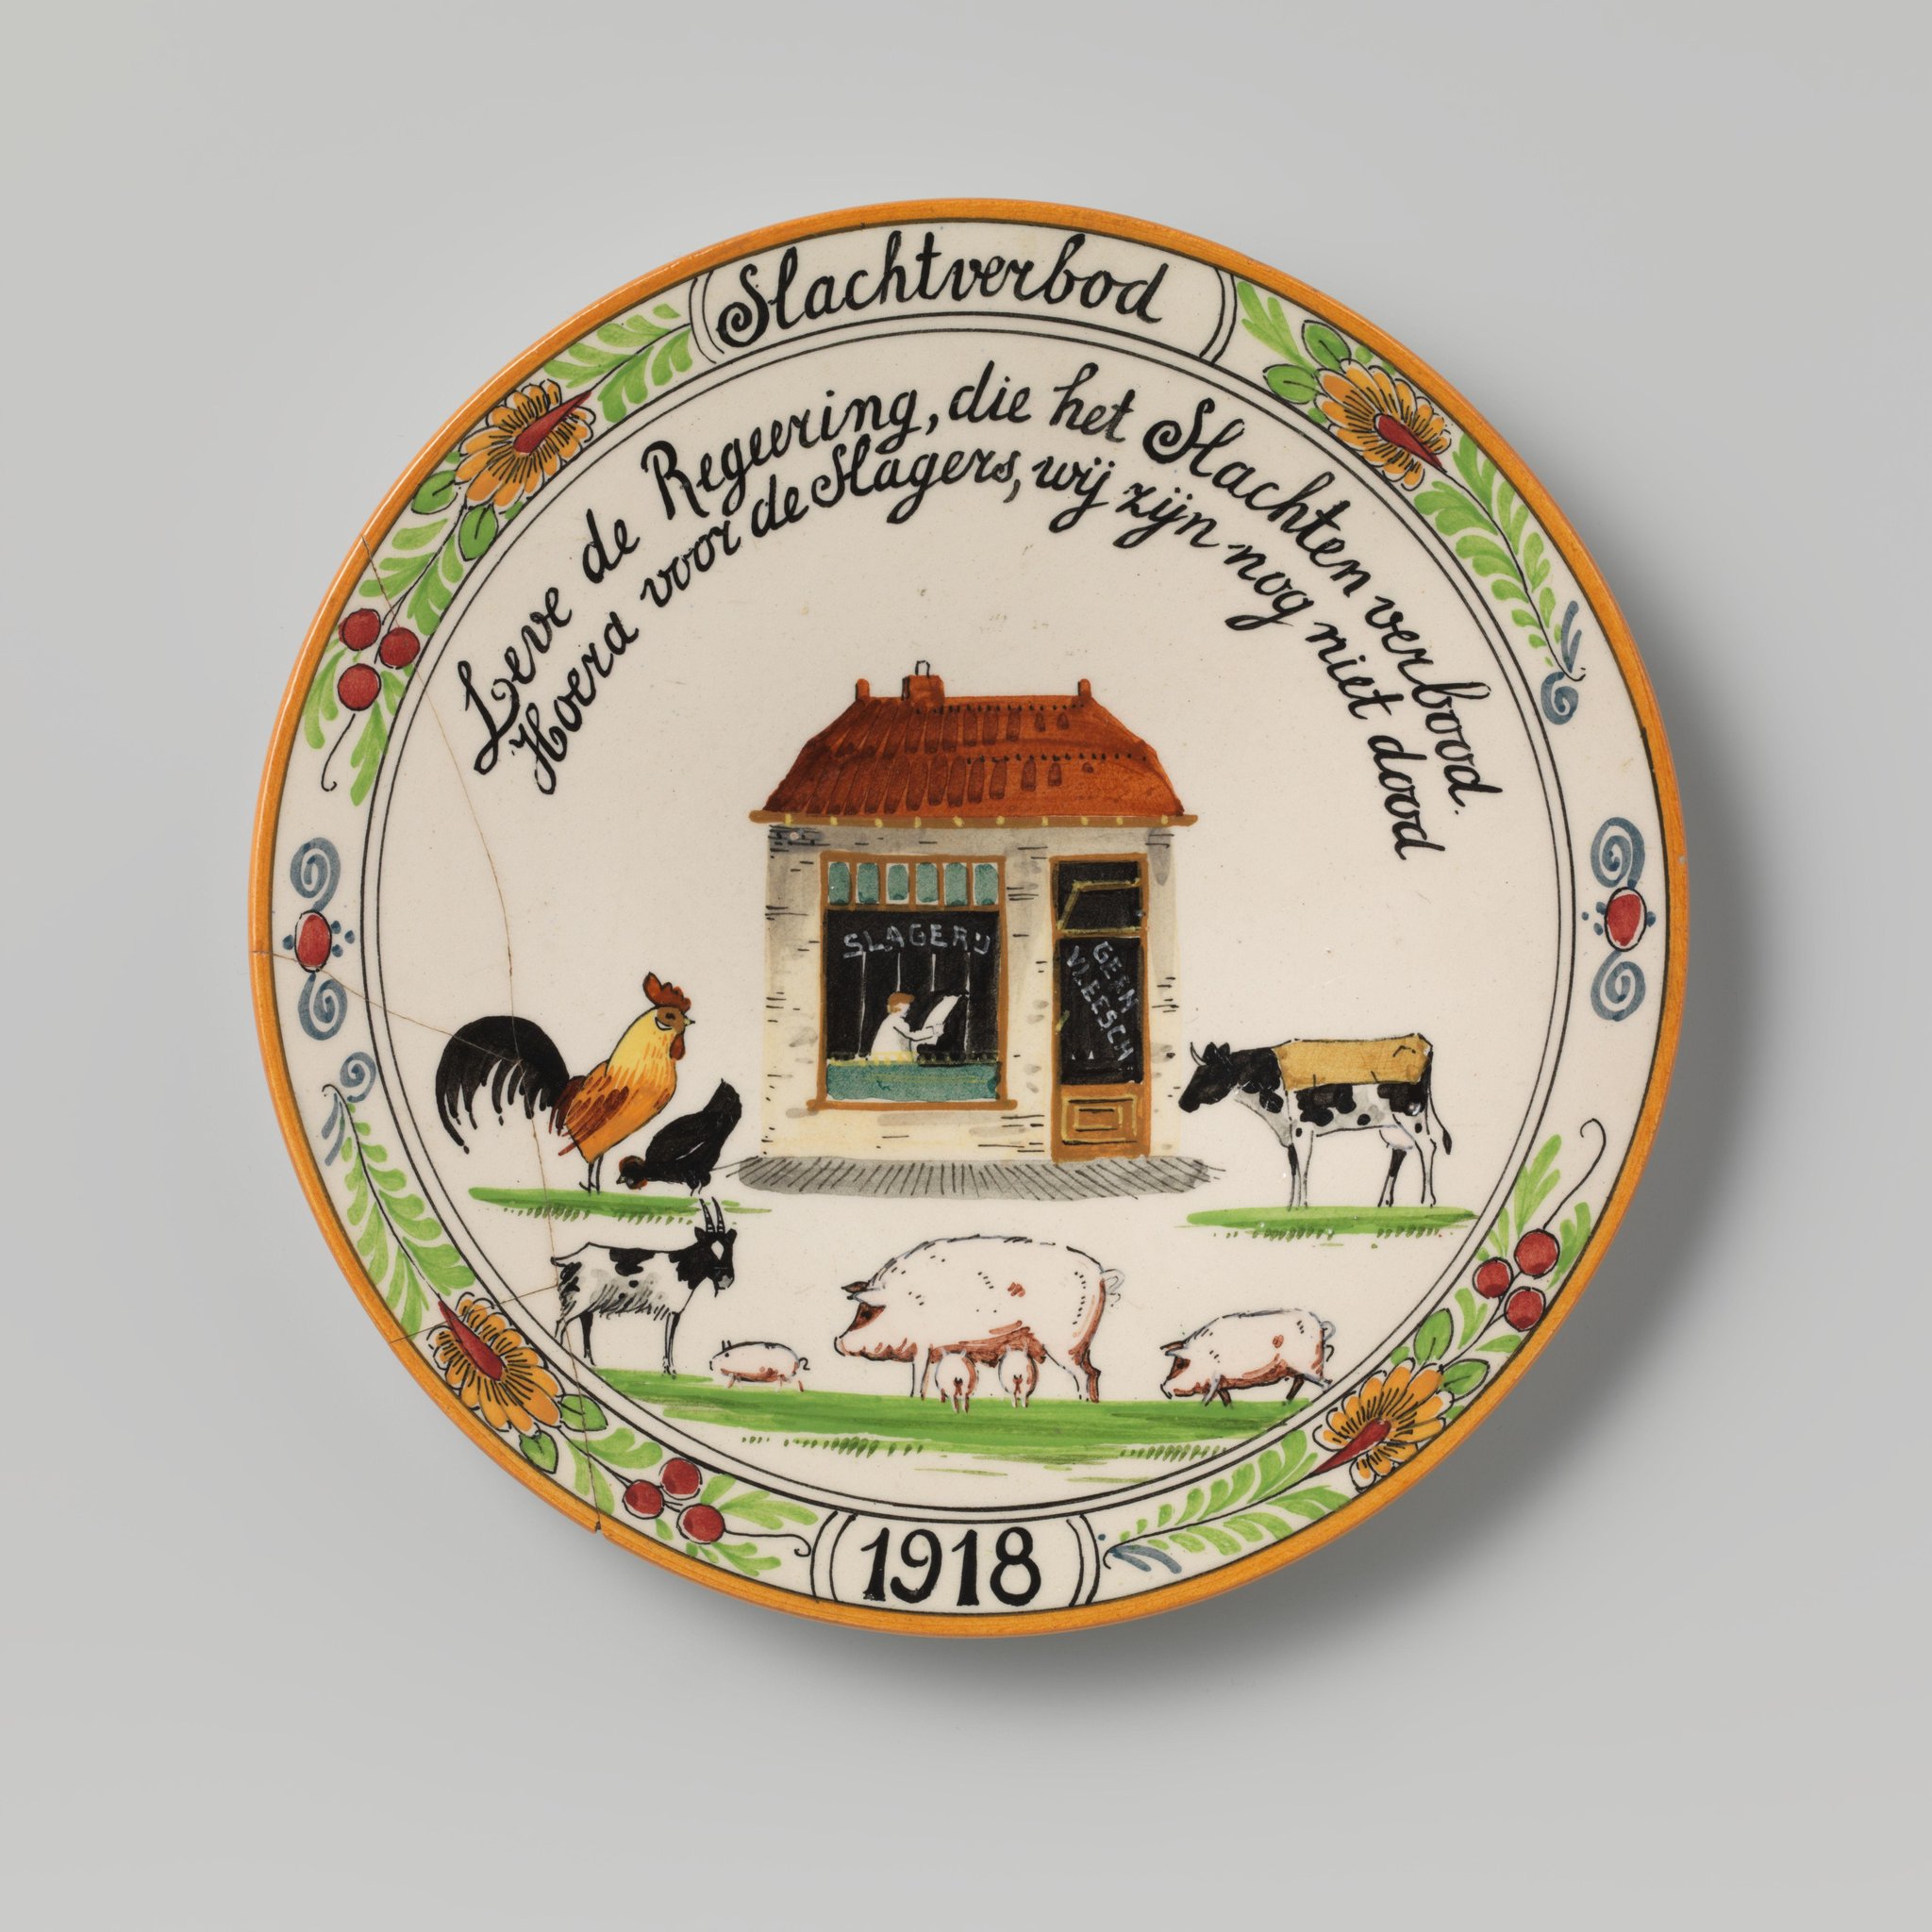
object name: commemorative plate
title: Herdenkingsbord "slachtverbod"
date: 1918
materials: earthenware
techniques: firing, painted, vitrification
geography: gouda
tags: cattle, butcher, slaughterman, netherlands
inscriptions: inscription: ‘Slachtverbod Leve de Regeering, die het Slachten verbood. Hoera voor de Slagers, wij zijn nog niet dood’